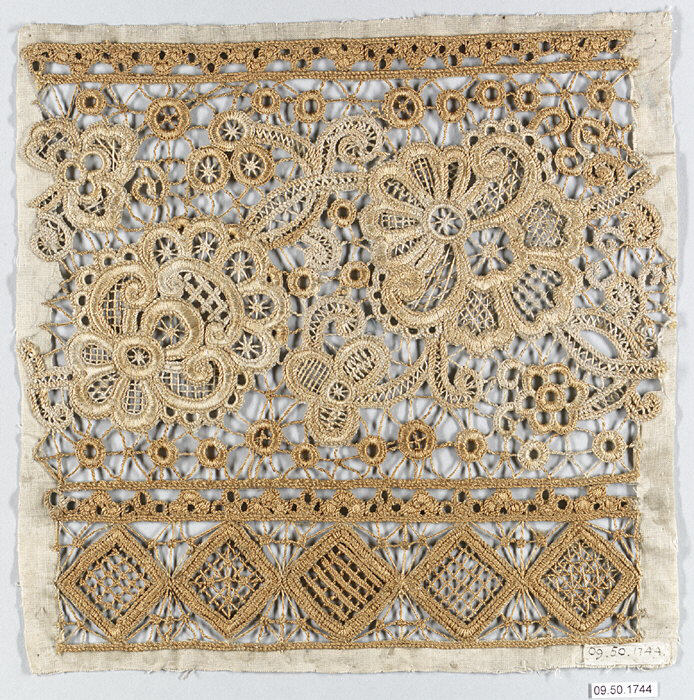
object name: fragment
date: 1801-1900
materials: lace, silk